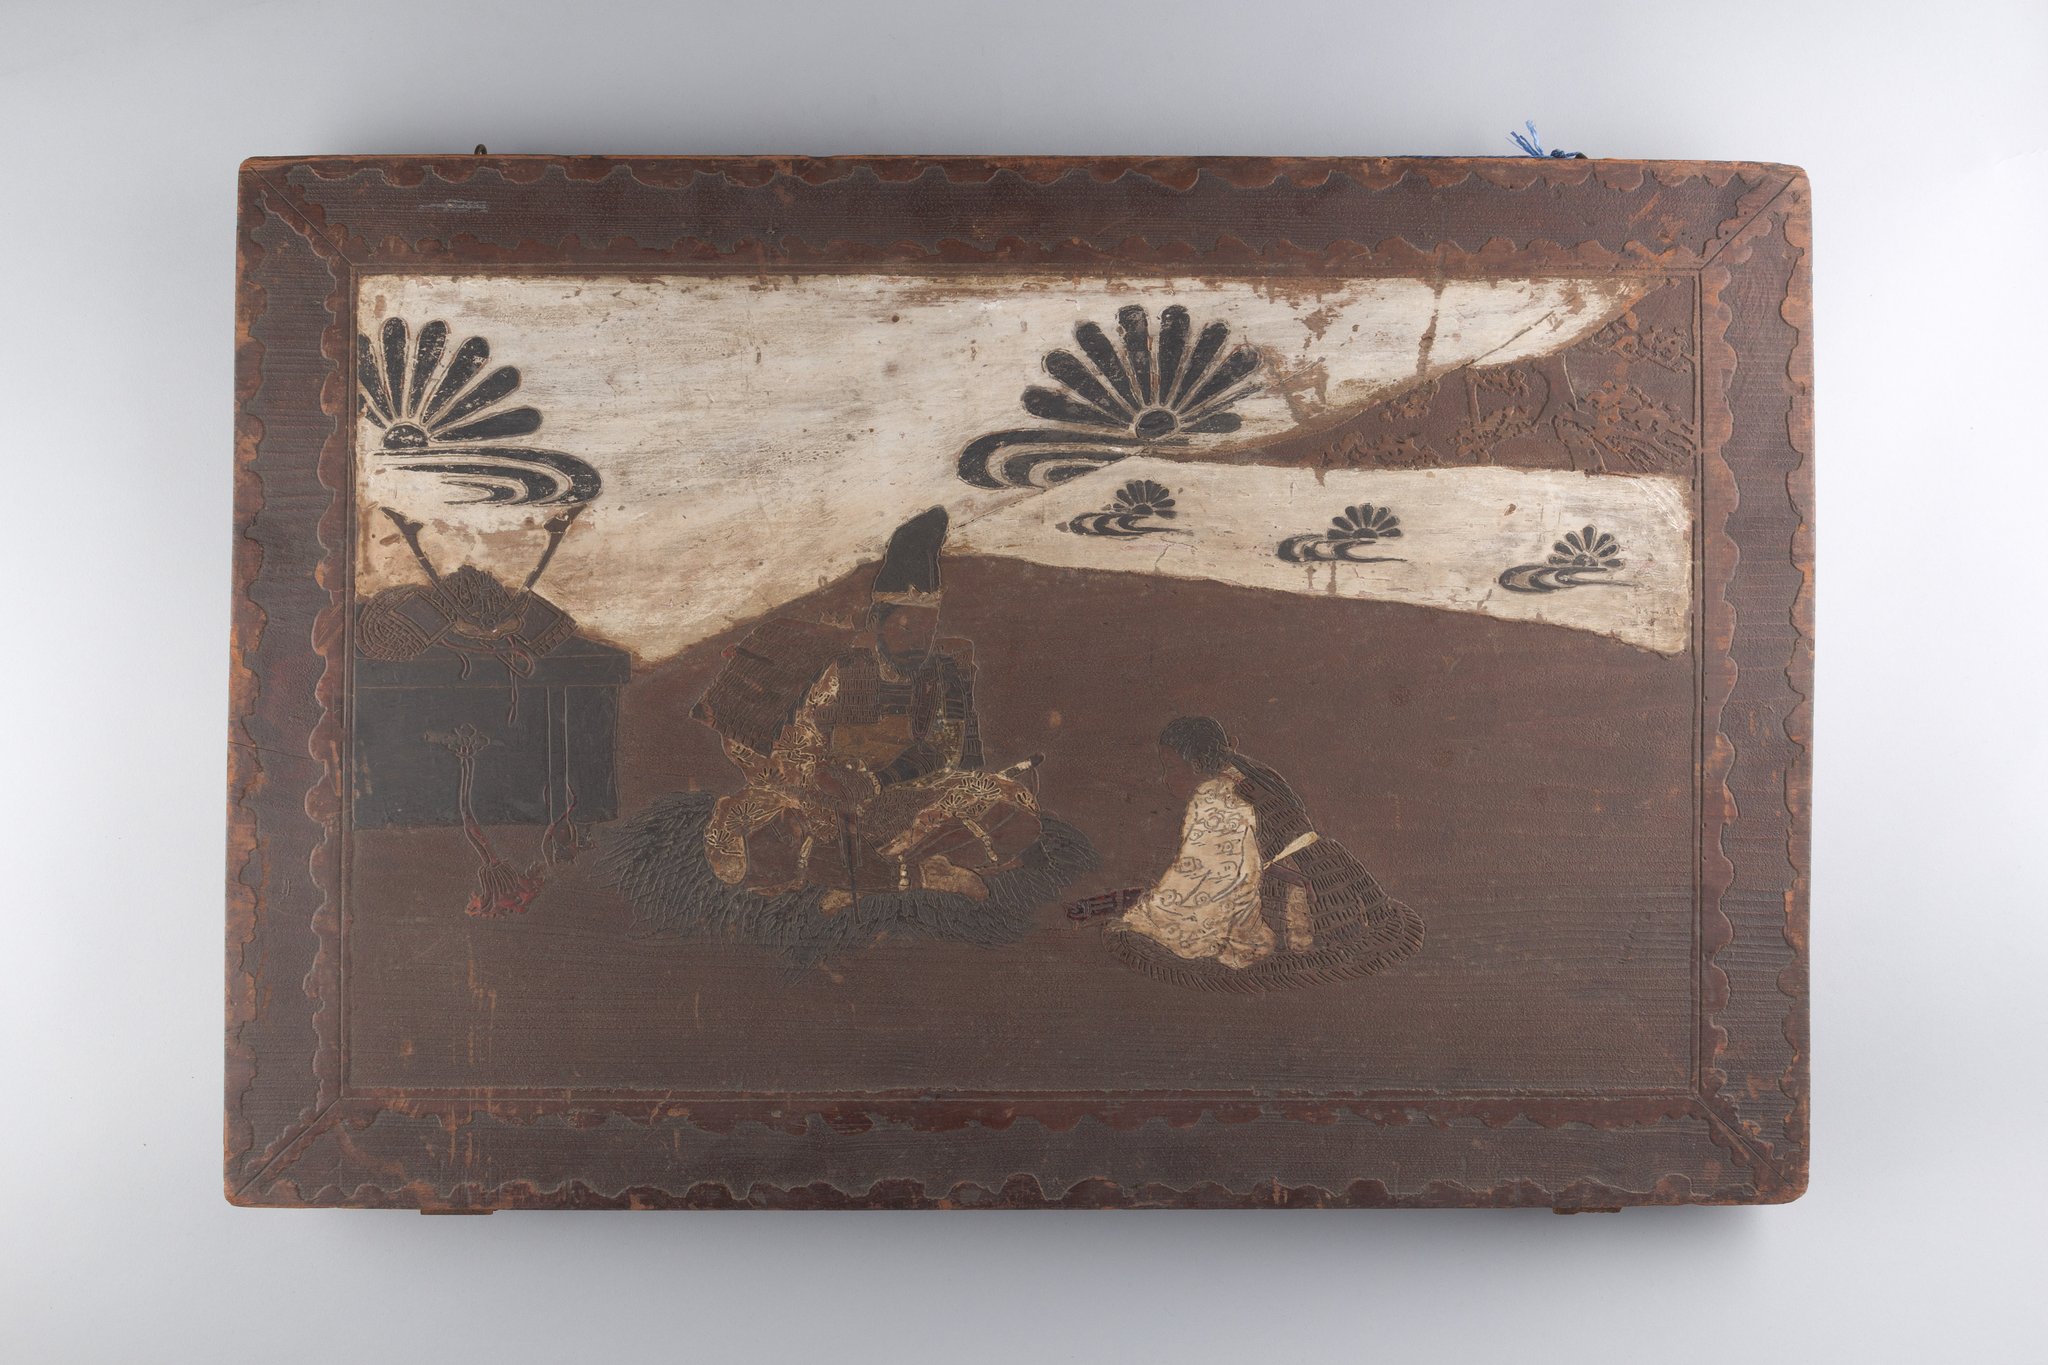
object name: votive plaque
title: Kusunoki Masashige Bidding Farewell to His Son Masatsura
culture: japanese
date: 1801-1900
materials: ink, wood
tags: hats,sadness,boys,men,fathers